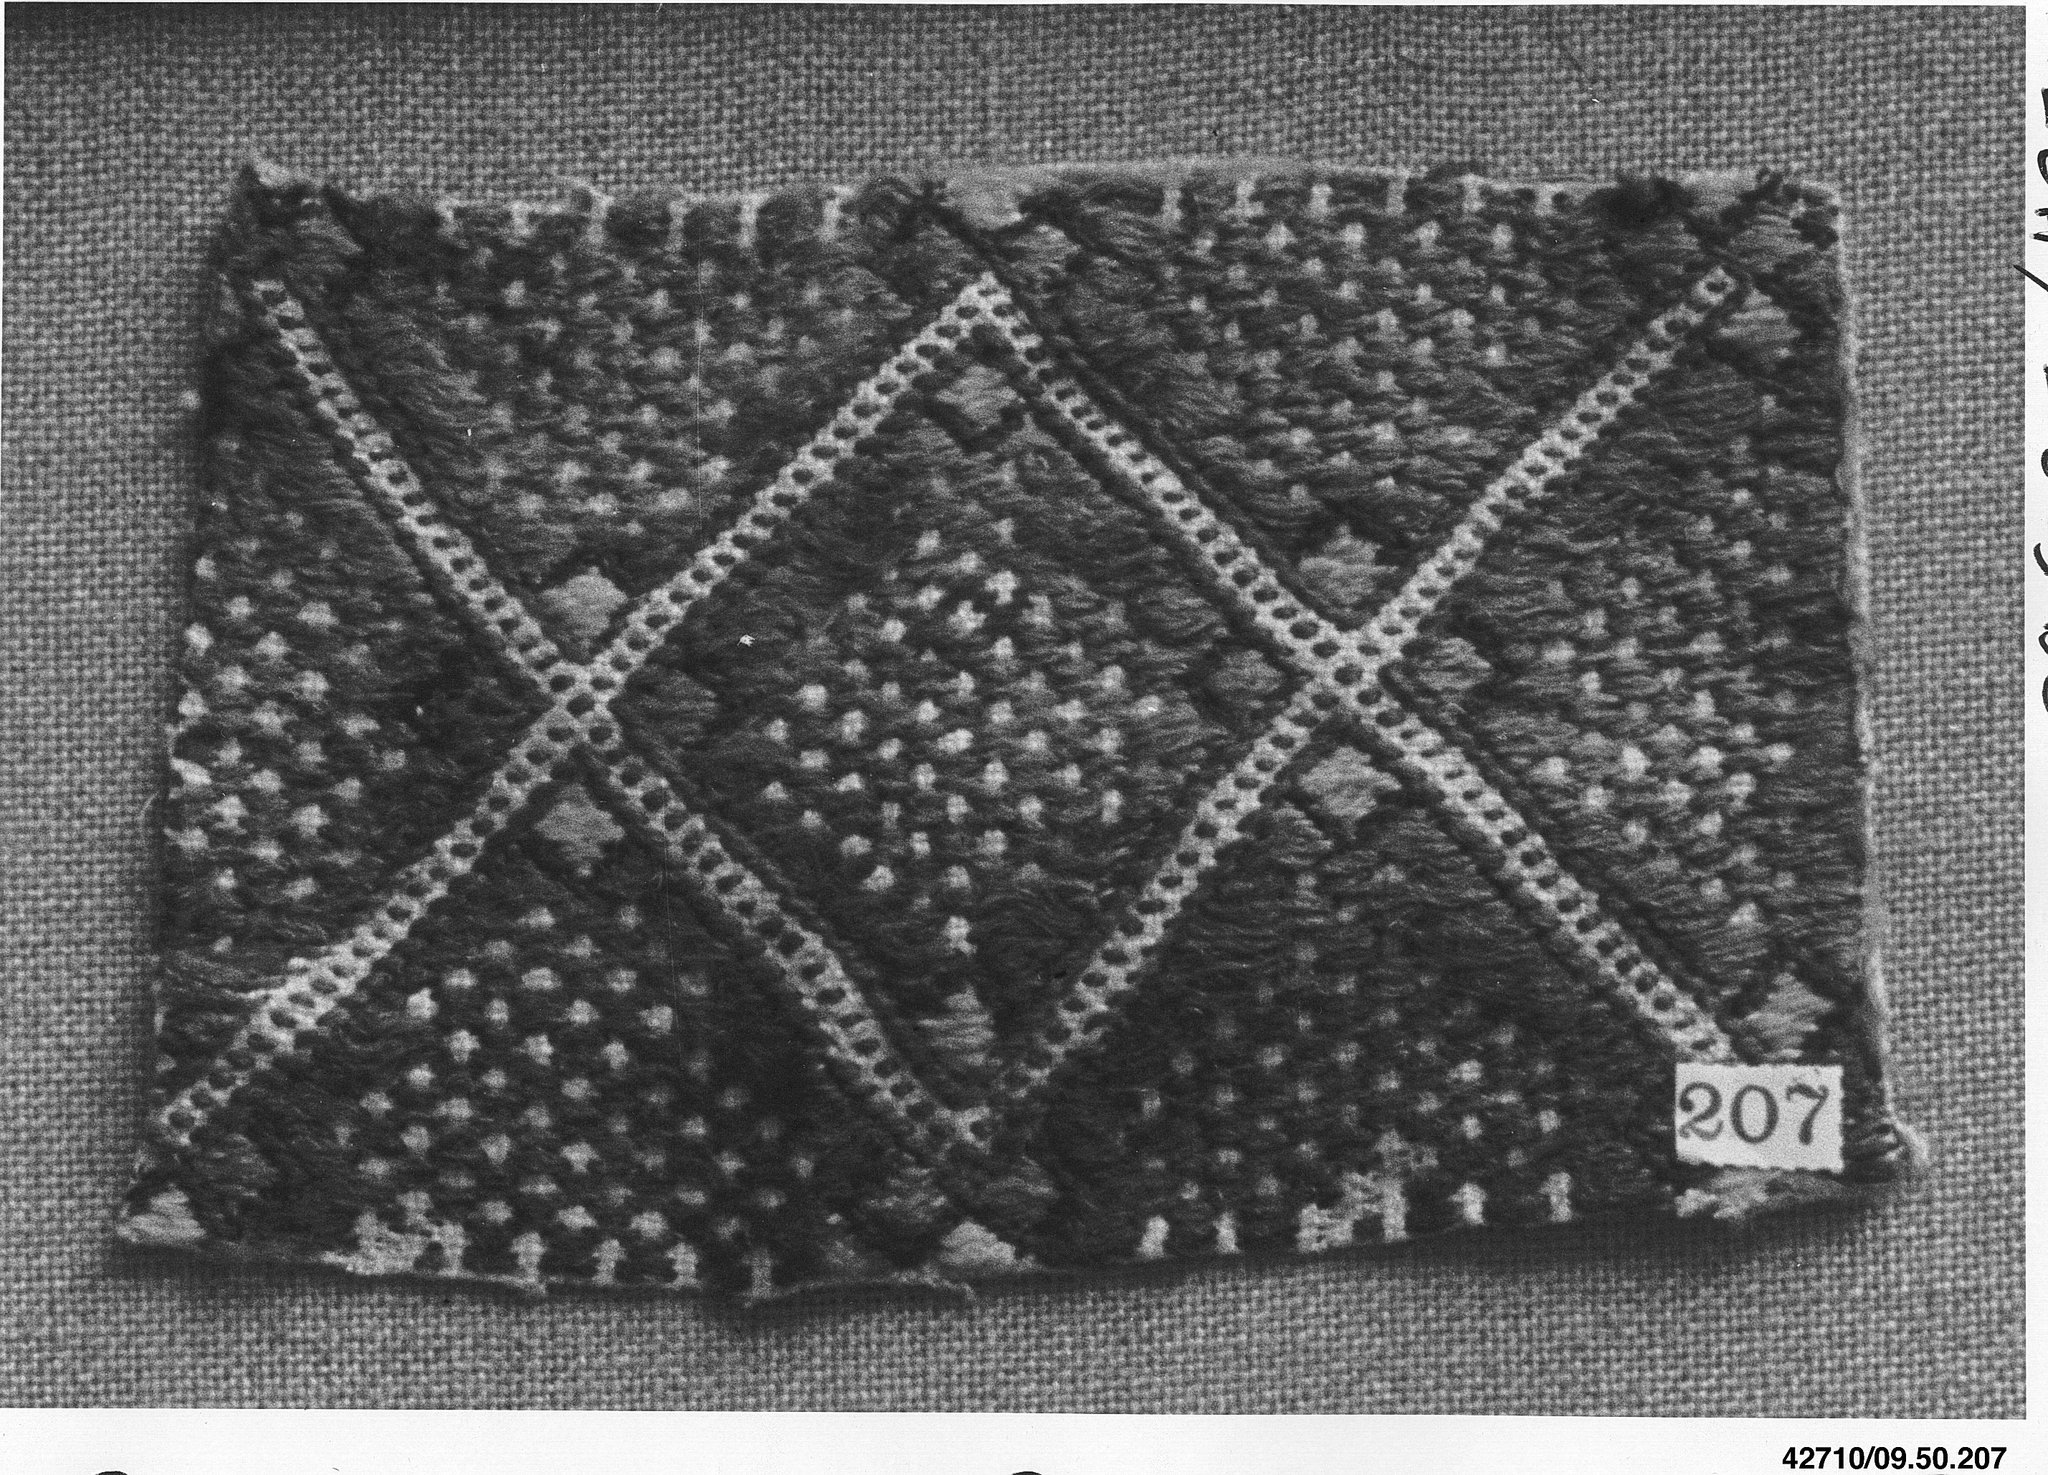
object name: costume fragment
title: Peasant costume fragment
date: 1701-1900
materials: canvas, wool